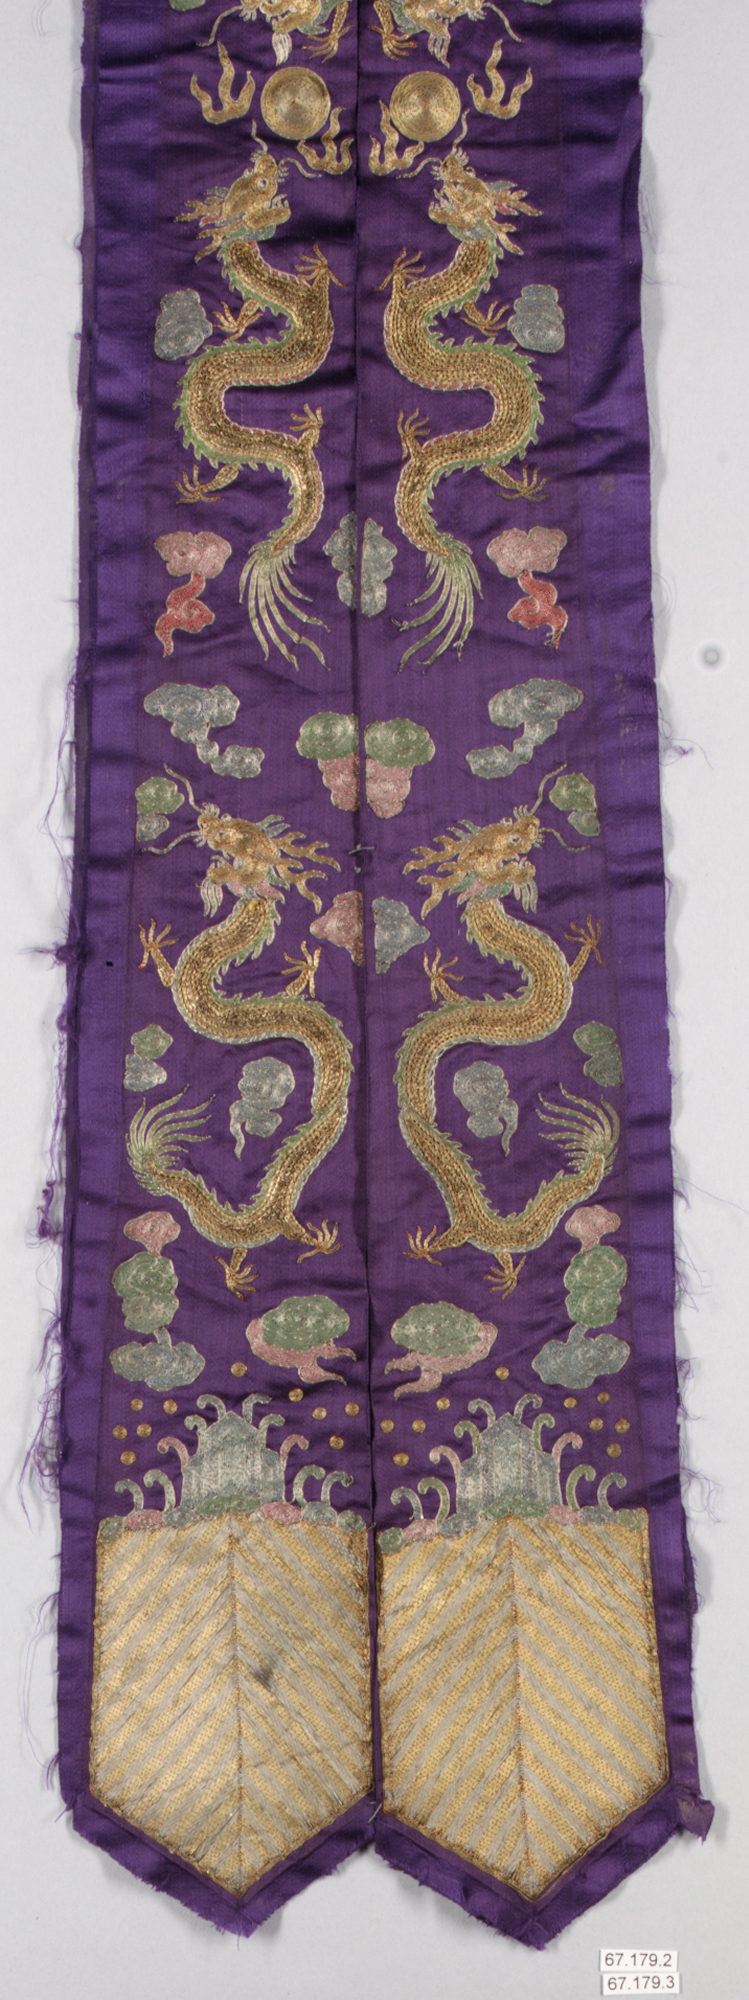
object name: streamer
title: Streamers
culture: chinese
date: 1801-1900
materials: metal thread, silk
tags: dragons,flags